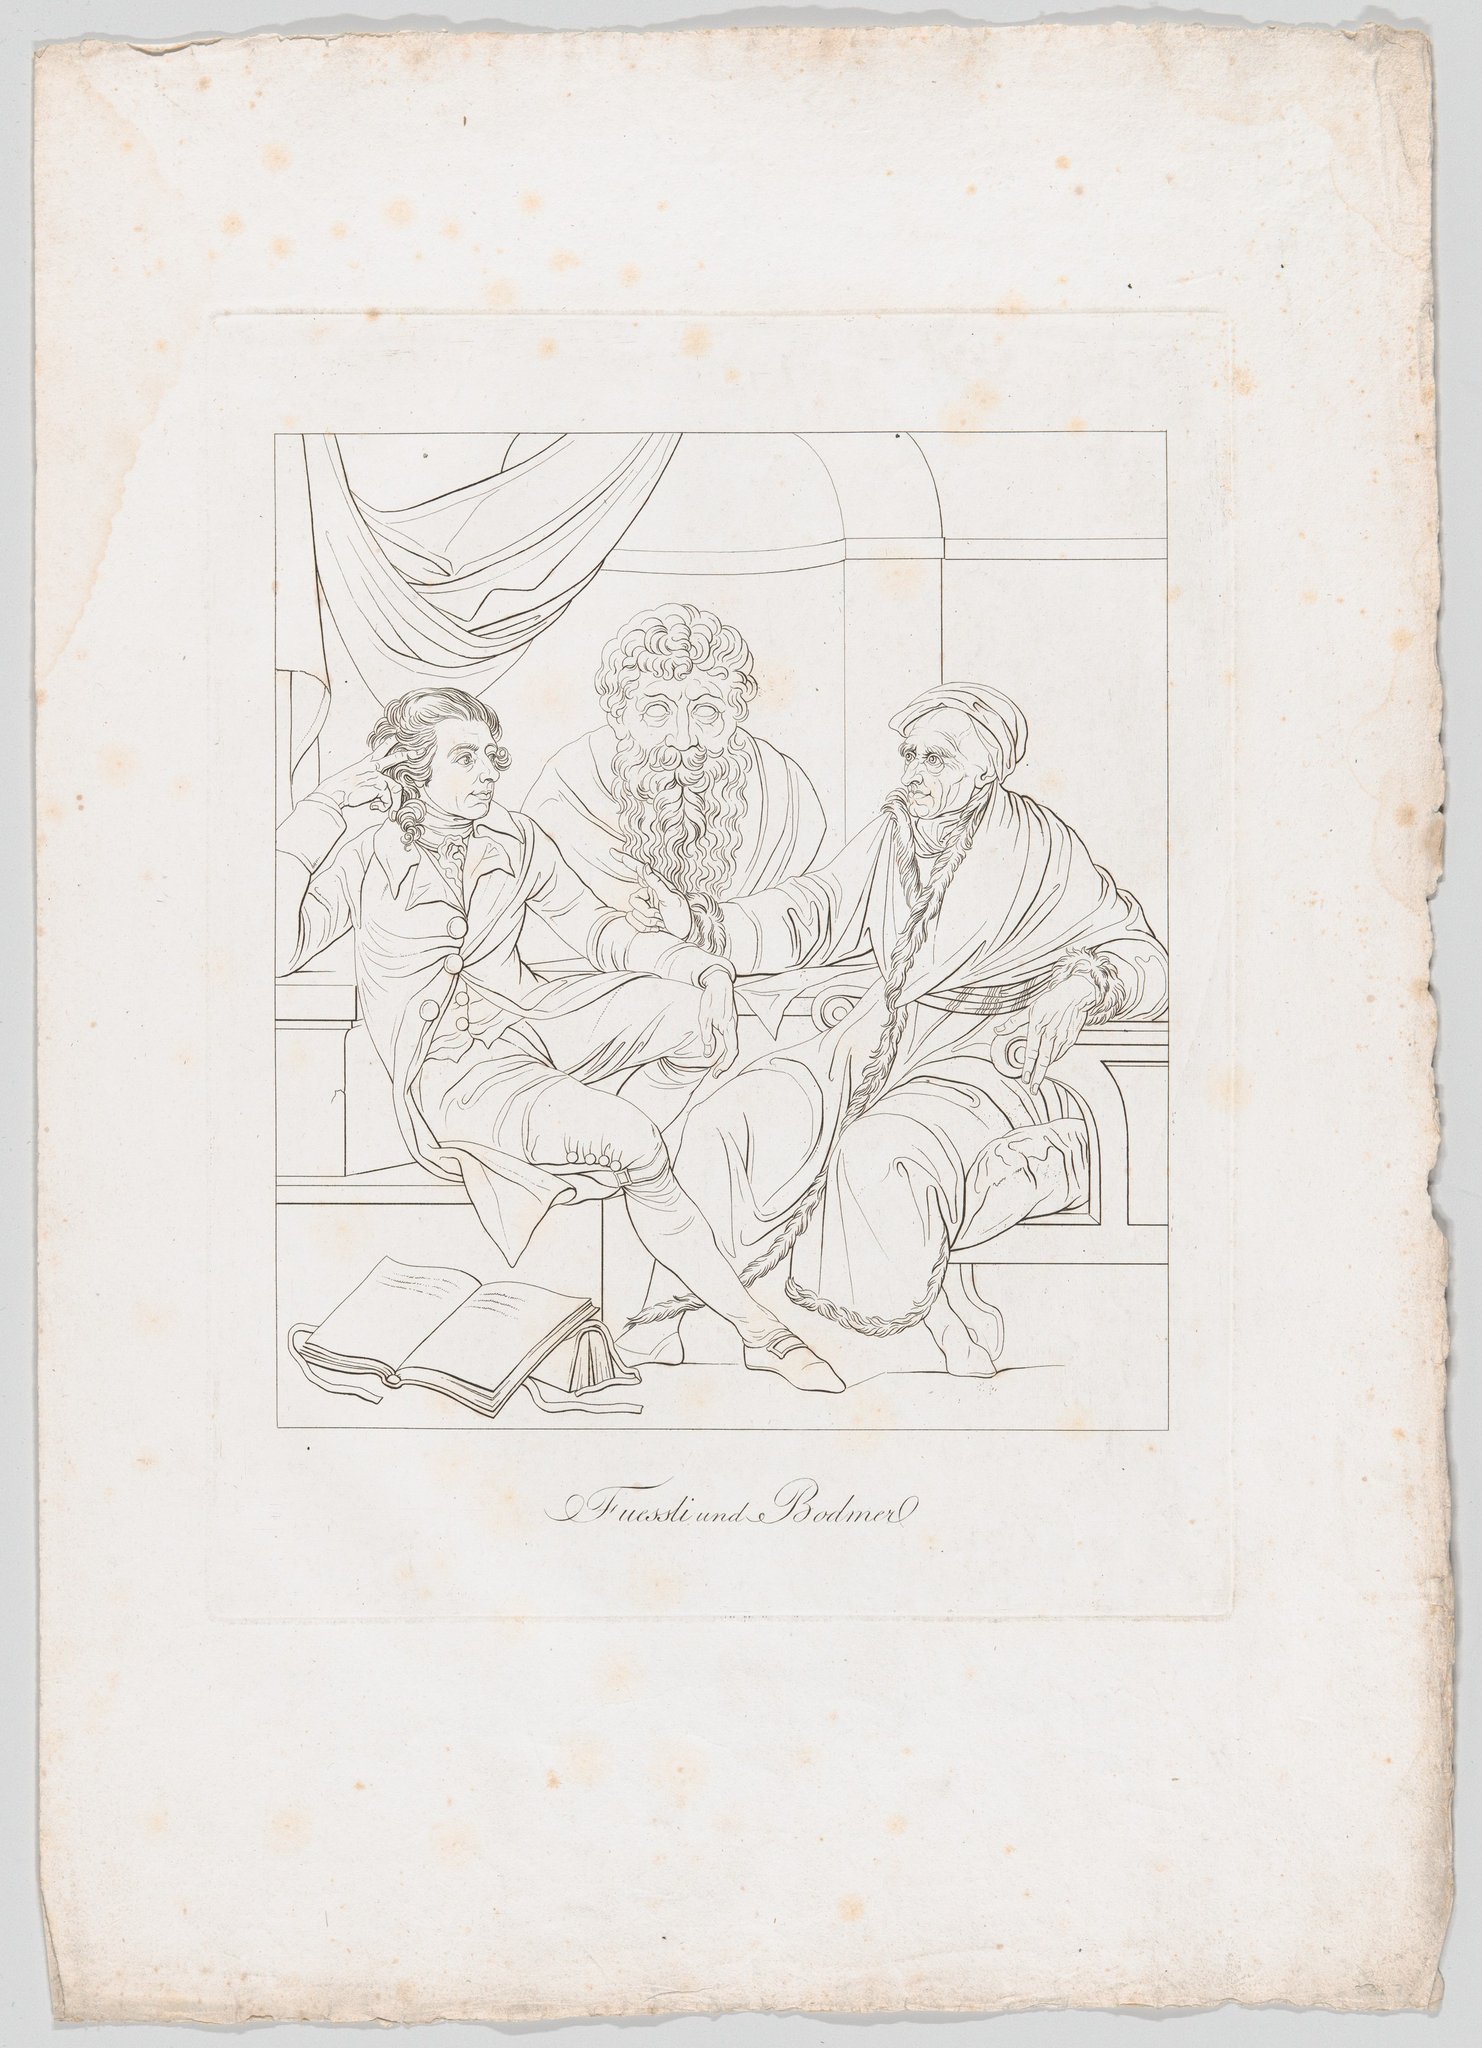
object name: print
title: Fuessli und Bodmer (Fuseli and Bodmer in Conversation)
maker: johann heinrich lips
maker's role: engraver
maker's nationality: swiss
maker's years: 1758-1817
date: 1806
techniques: engraving, etching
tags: men